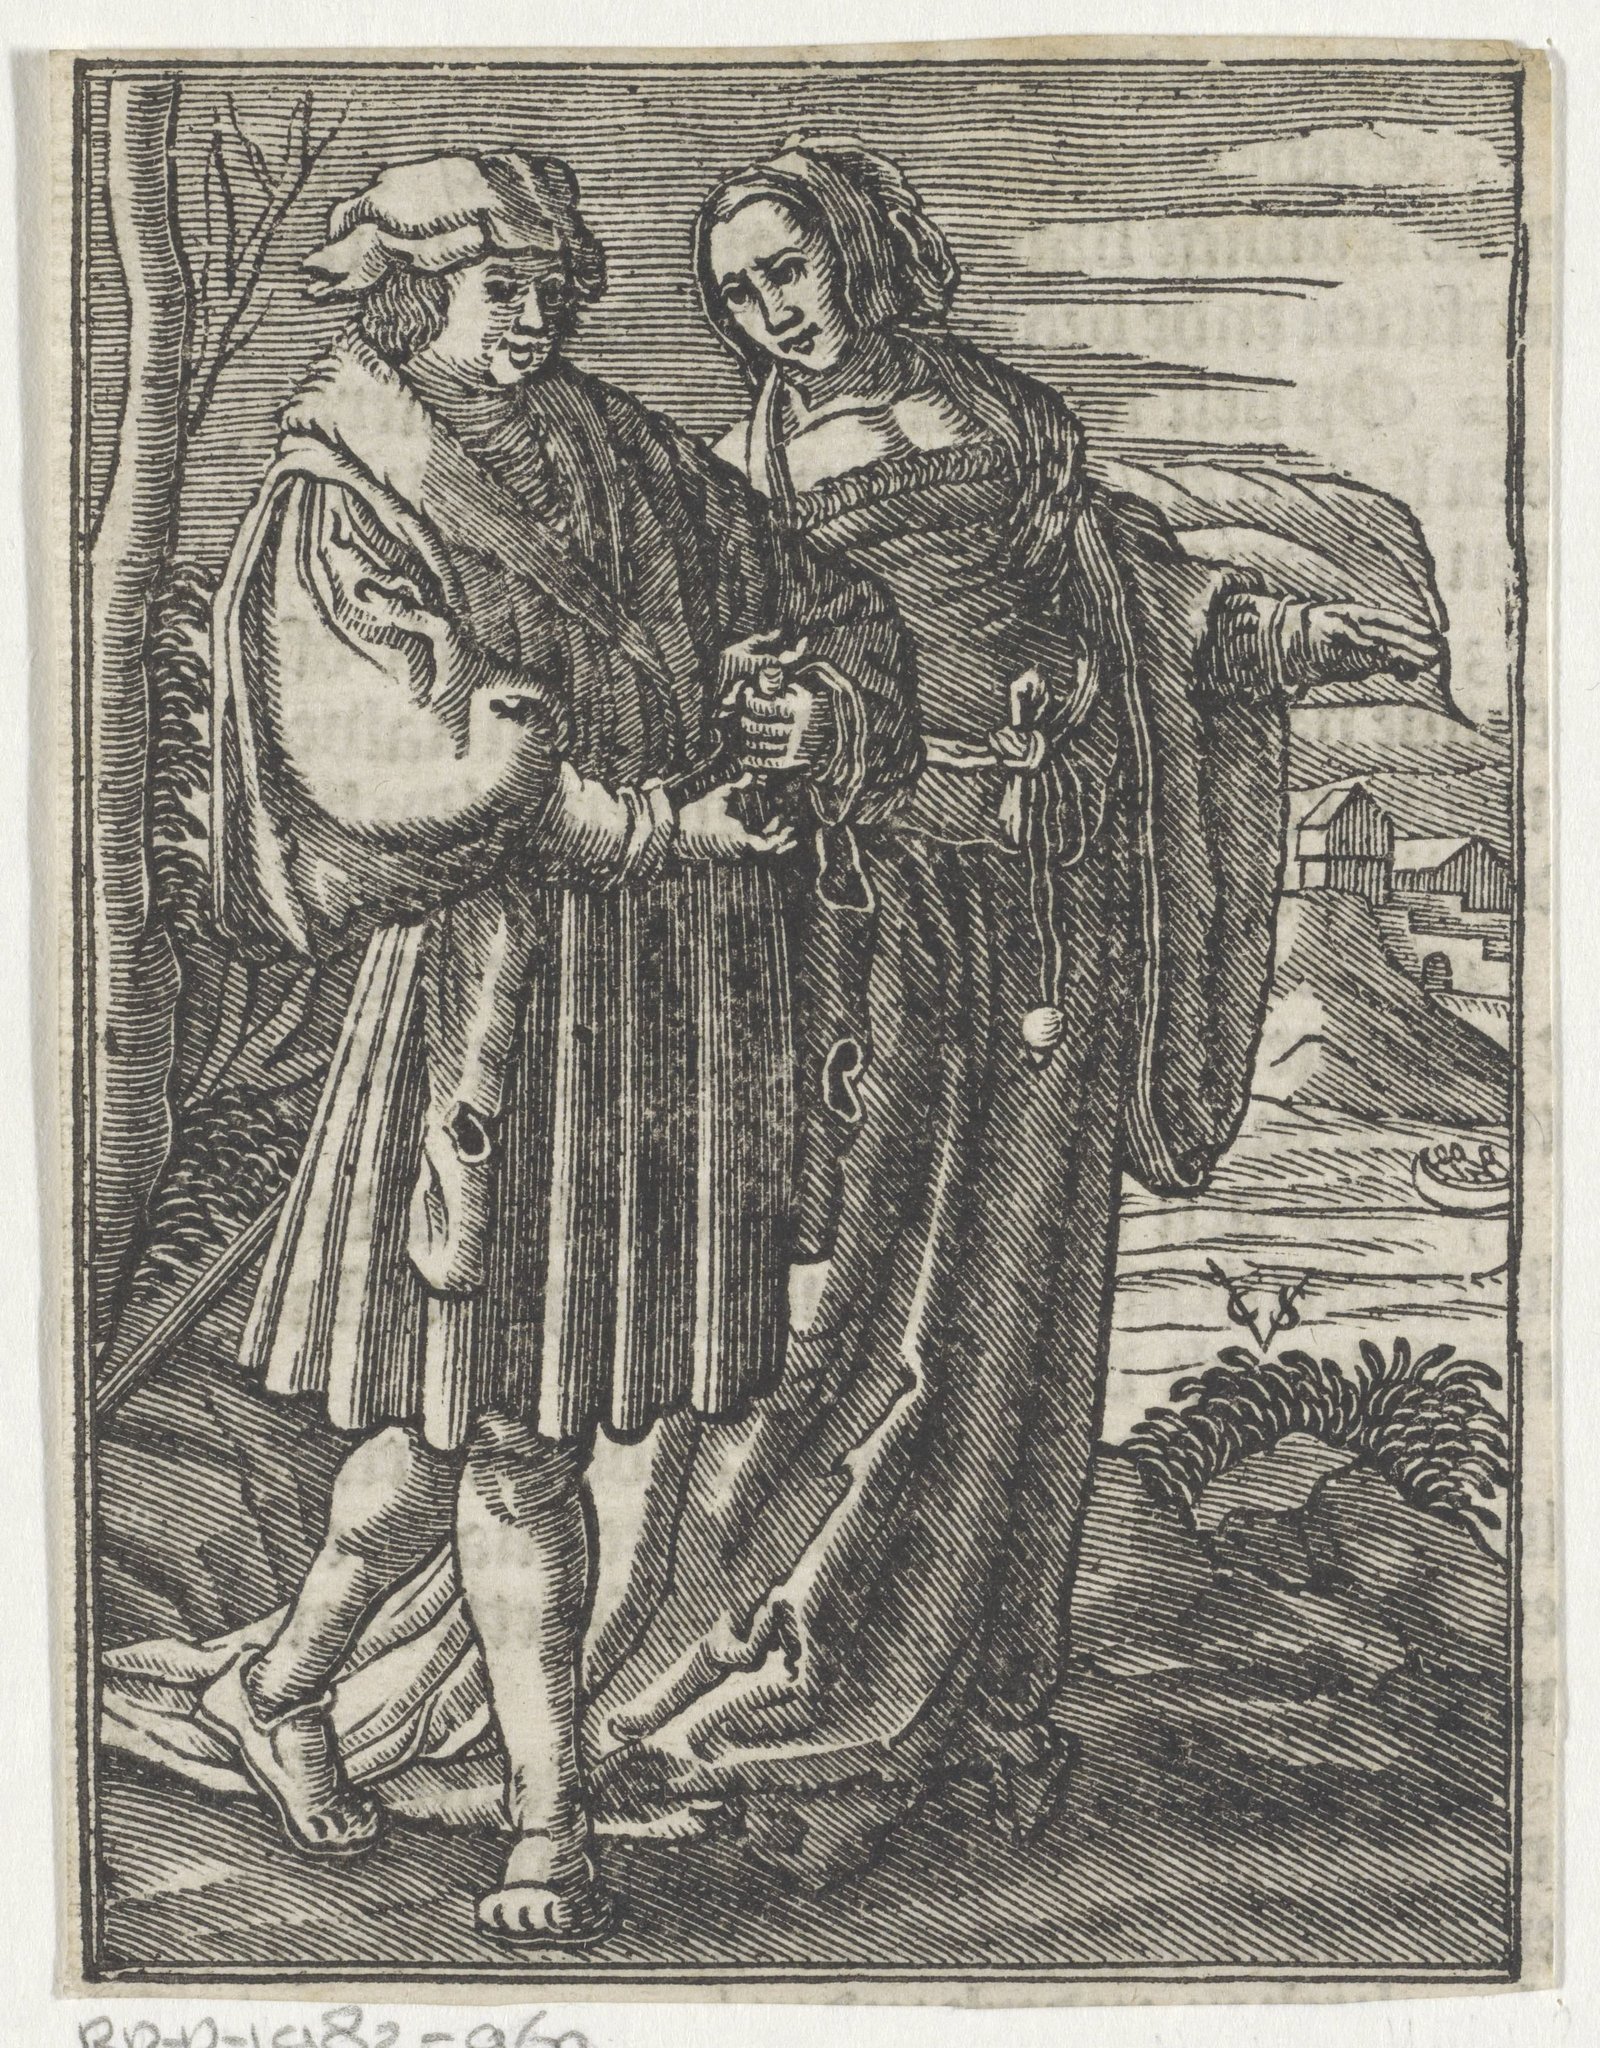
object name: book illustration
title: Wandelend paar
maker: christoffel van sichem (ii)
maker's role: print maker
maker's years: 1581-1658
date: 1581-1658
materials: paper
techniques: letterpress printing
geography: amsterdam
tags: strolling, head-gear: hat (+ men's clothes), dress, gown (+ women's clothes), arm in arm (lovers)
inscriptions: collector's mark: Lugt 2760, collector's mark: Lugt 2228